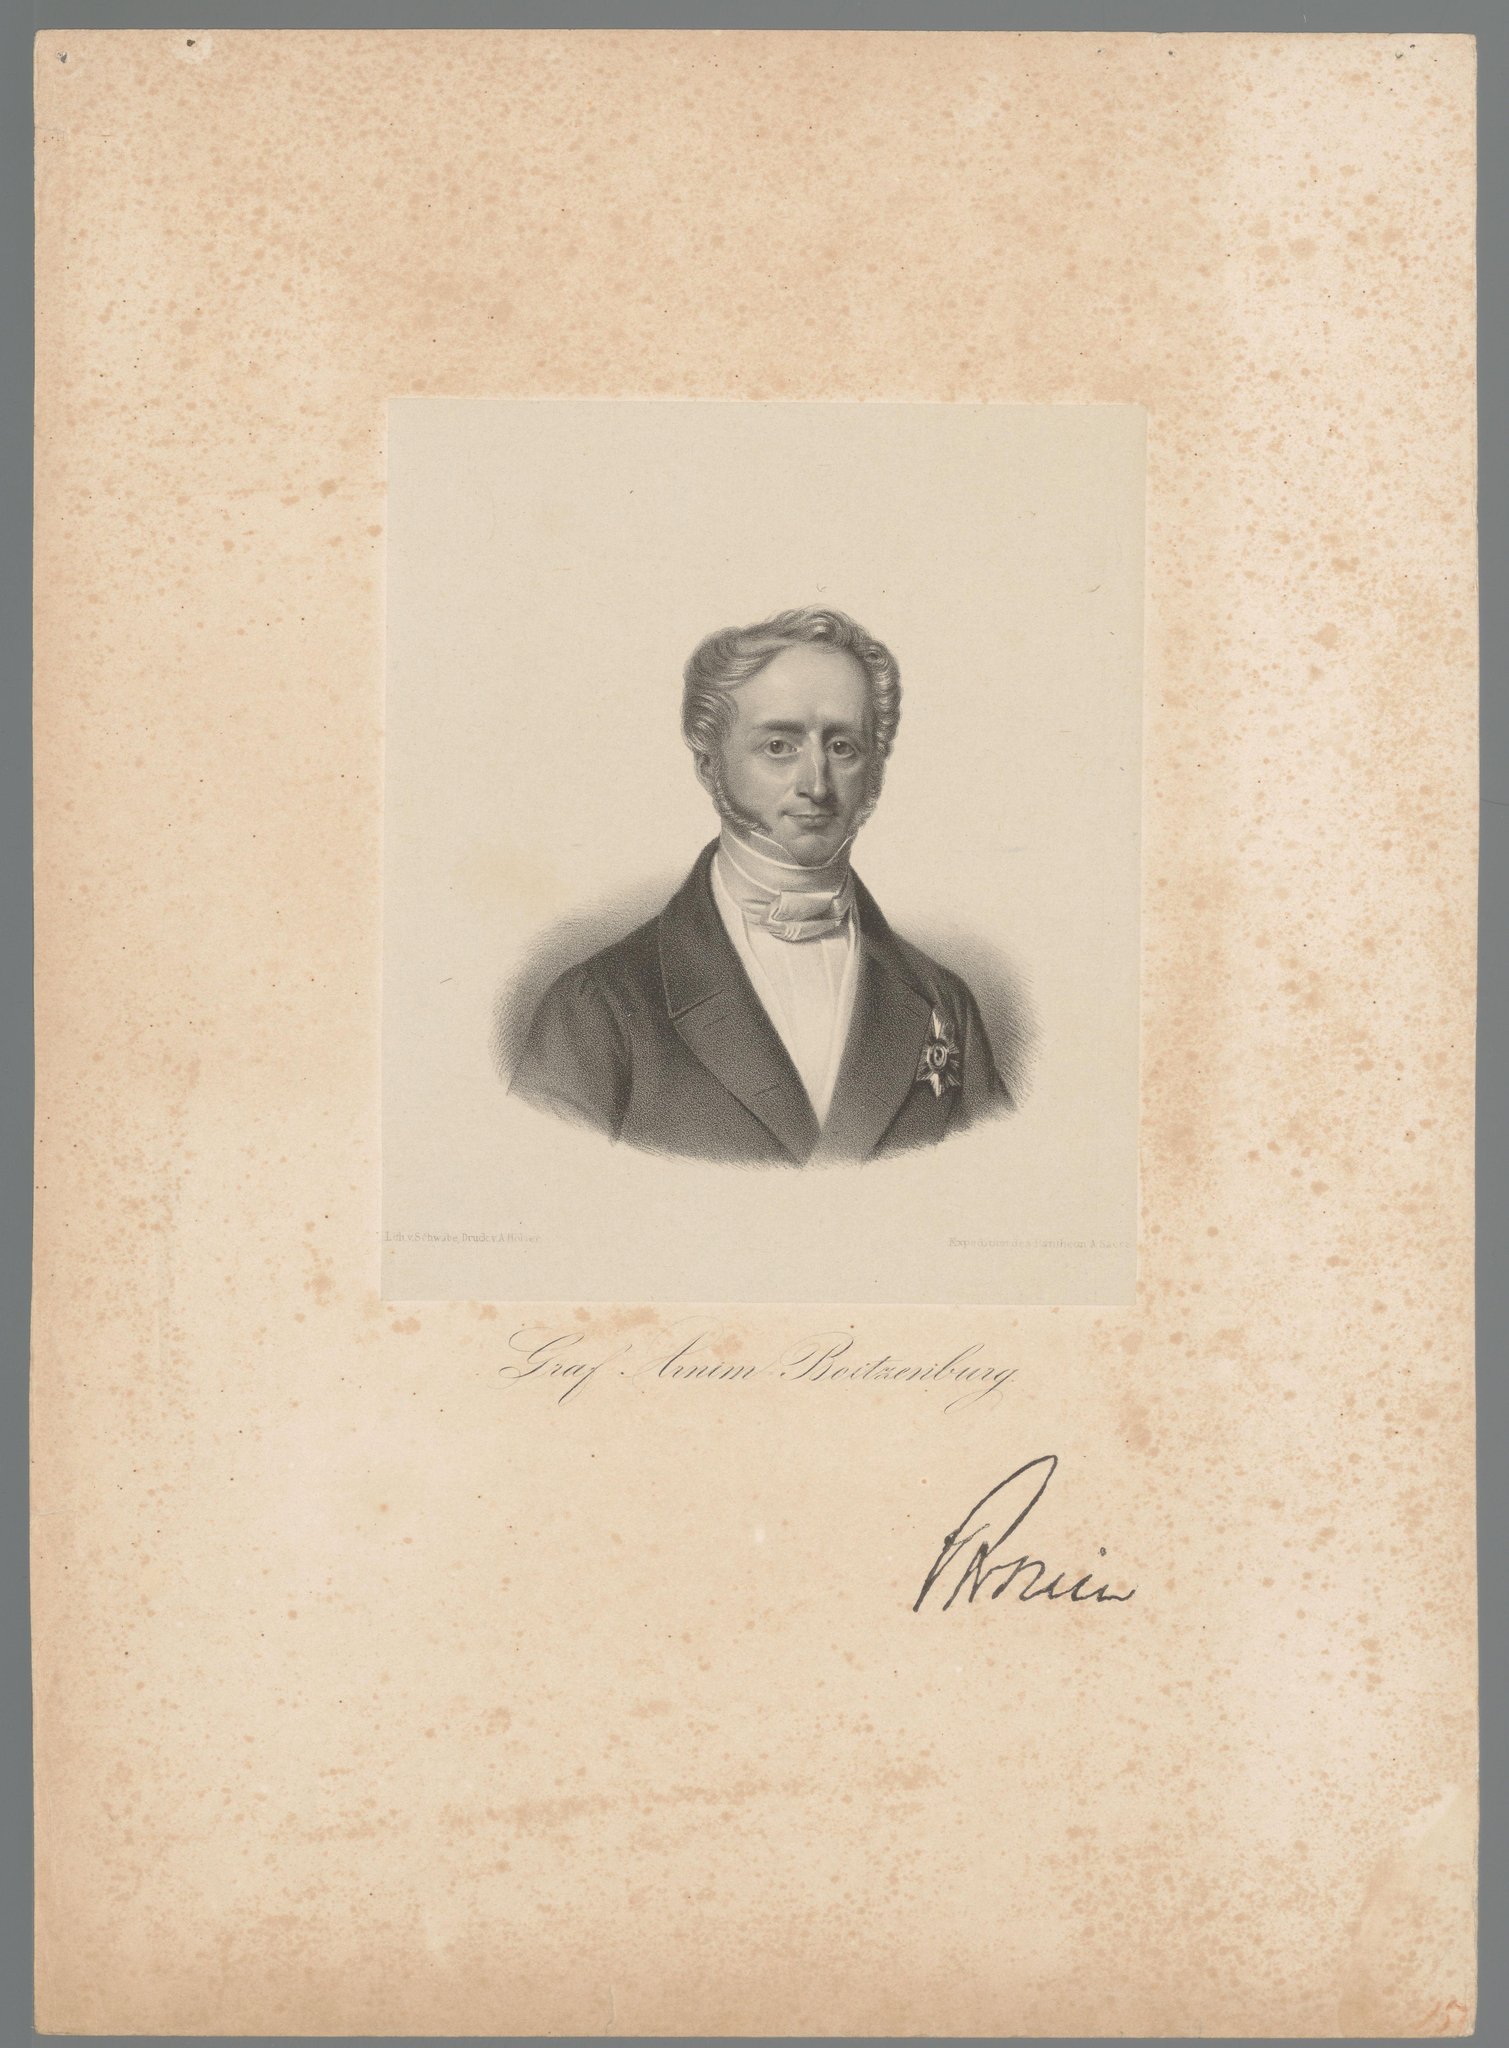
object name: print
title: Portret van Adolf Heinrich von Arnim-Boitzenburg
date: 1830-1860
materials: paper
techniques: lithograph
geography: berlin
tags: adult man, historical persons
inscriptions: collector's mark: Lugt 2228